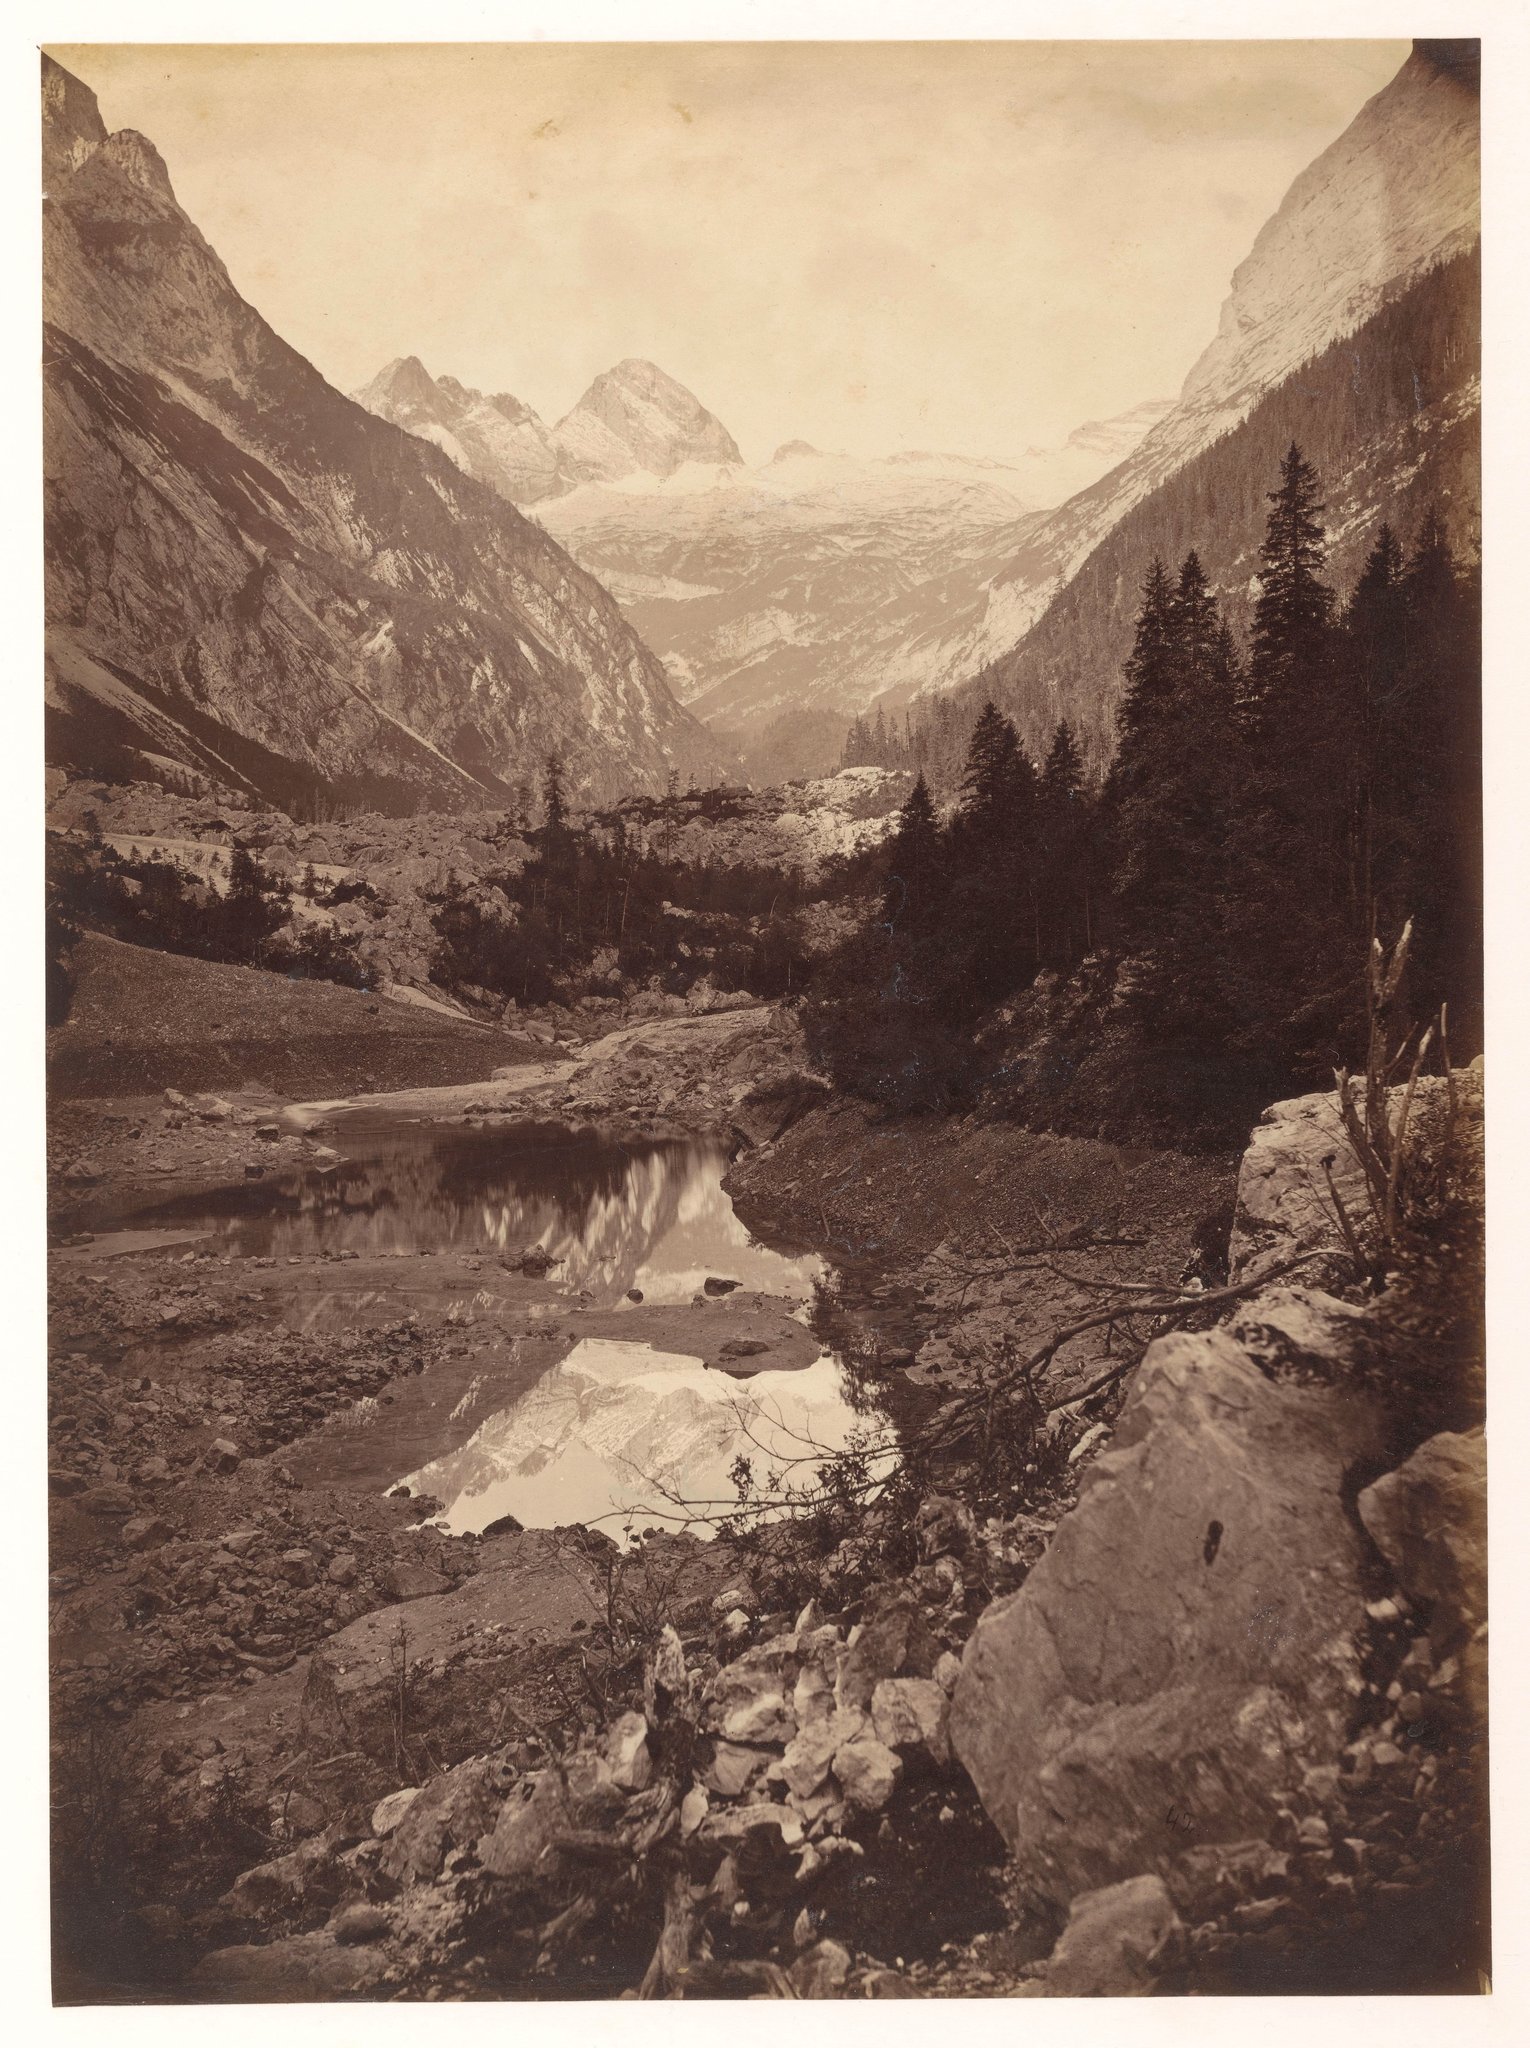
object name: photograph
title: Berglandschap met bergmeer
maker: Anonymous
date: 1855-1880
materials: paper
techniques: albumen print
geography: germany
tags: lake, mountains, germany